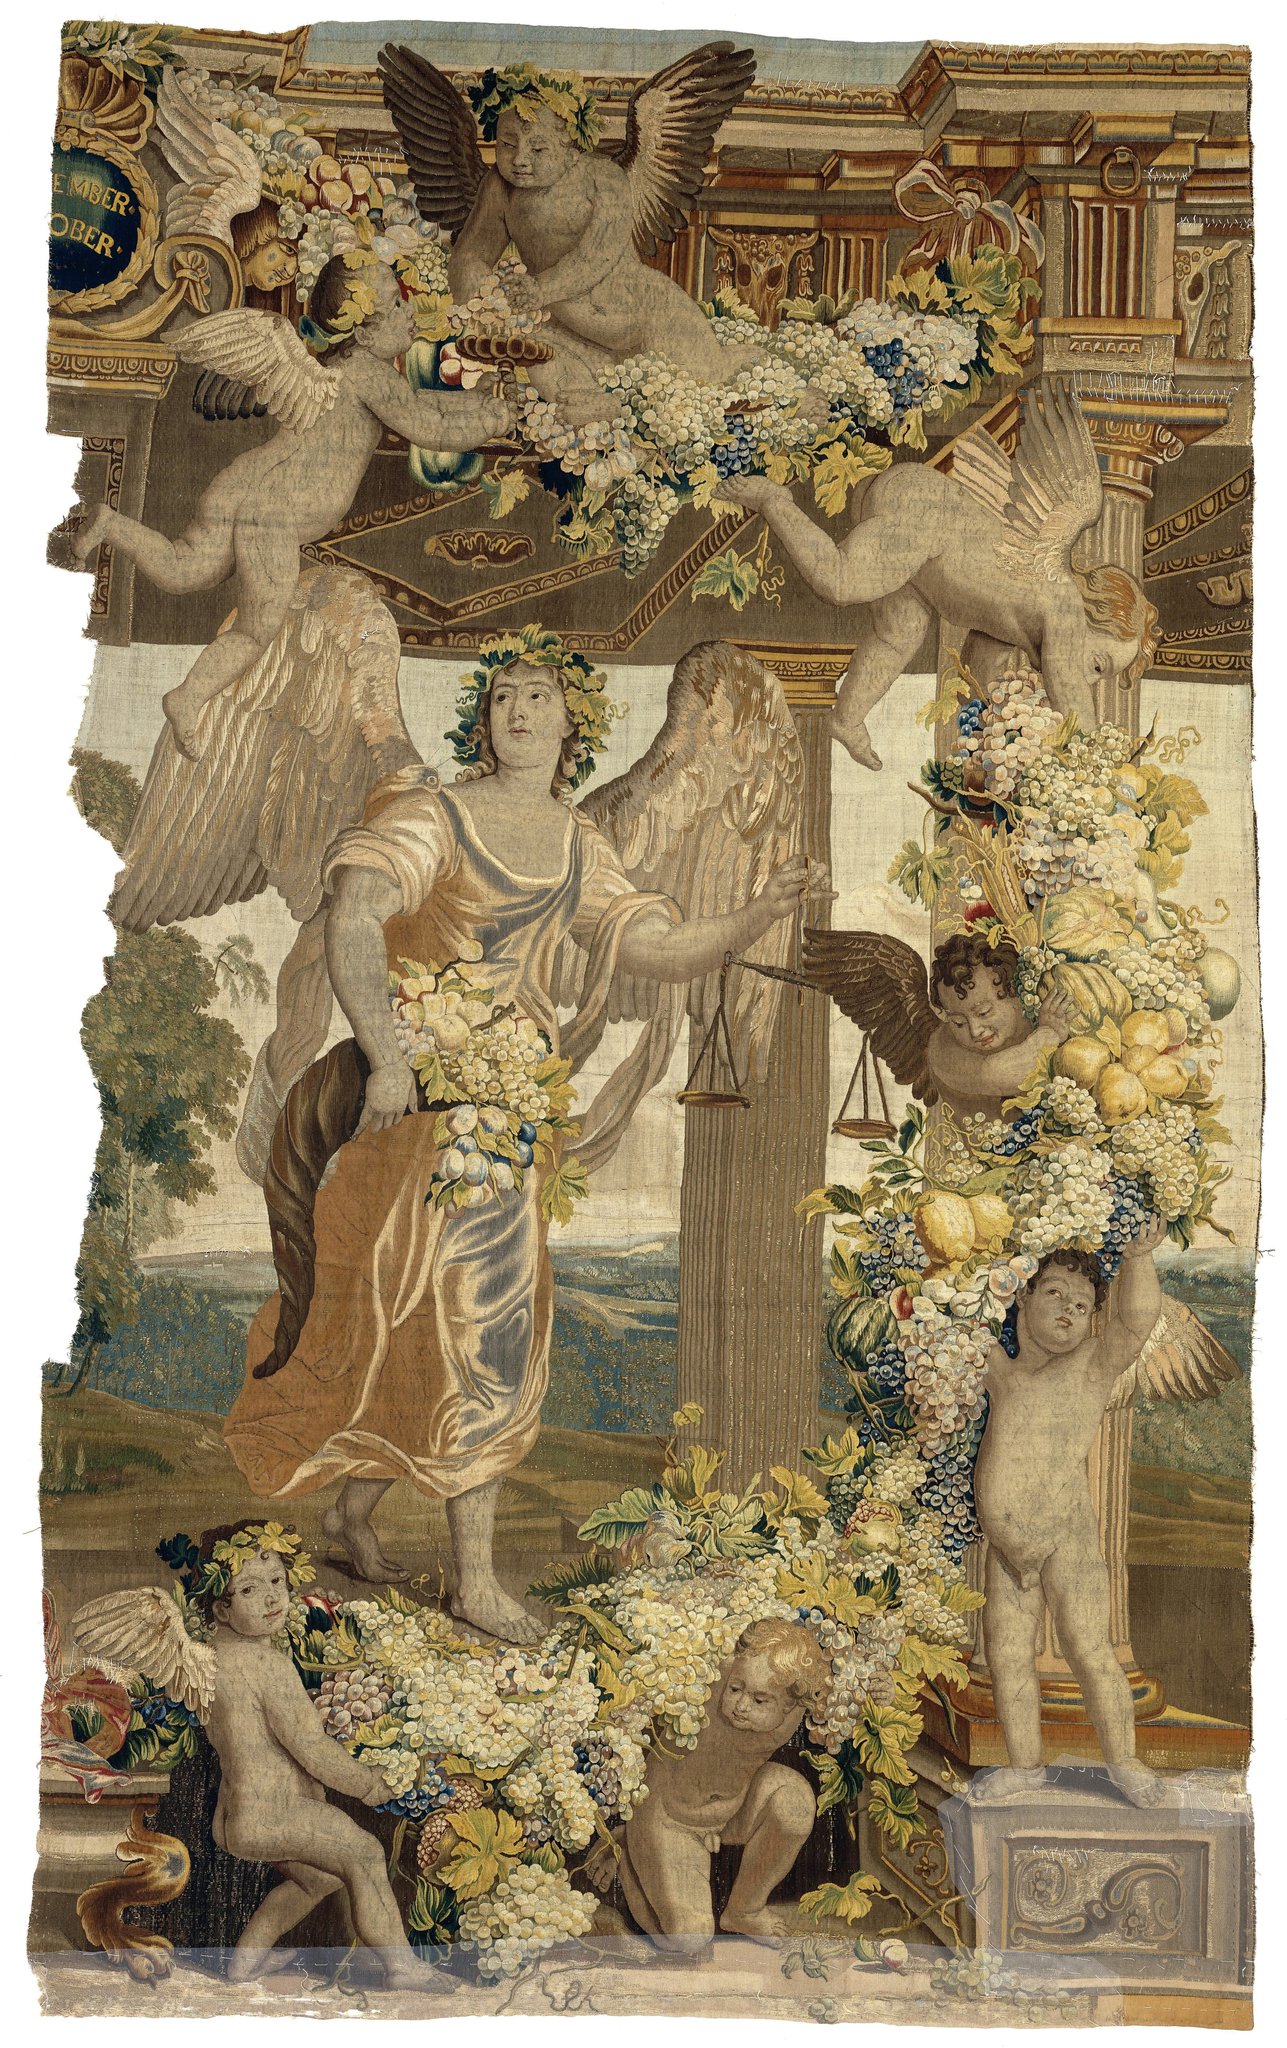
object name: tapestry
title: De maanden, seizoenen, elementen, dag en nacht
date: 1650-1680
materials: metal thread, silk, wool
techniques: tapestry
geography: antwerp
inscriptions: inscription: ‘EMBER // OBER’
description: Fragment van een wandtapijt voorstellende September en Oktober, behorende tot een serie van tien met de maanden, elementen, seizoenen, dag en nacht. De serie werd vervaardigd in opdracht van aartshertog Leopold Wilhelm, stadhouder der Zuidelijke Nederlanden. Op dit fragment staat een gevleugelde vrouw met een weegschaal in de linkerhand en een hoorn met vruchten in haar rechterhand, die de maand september verbeeldt.